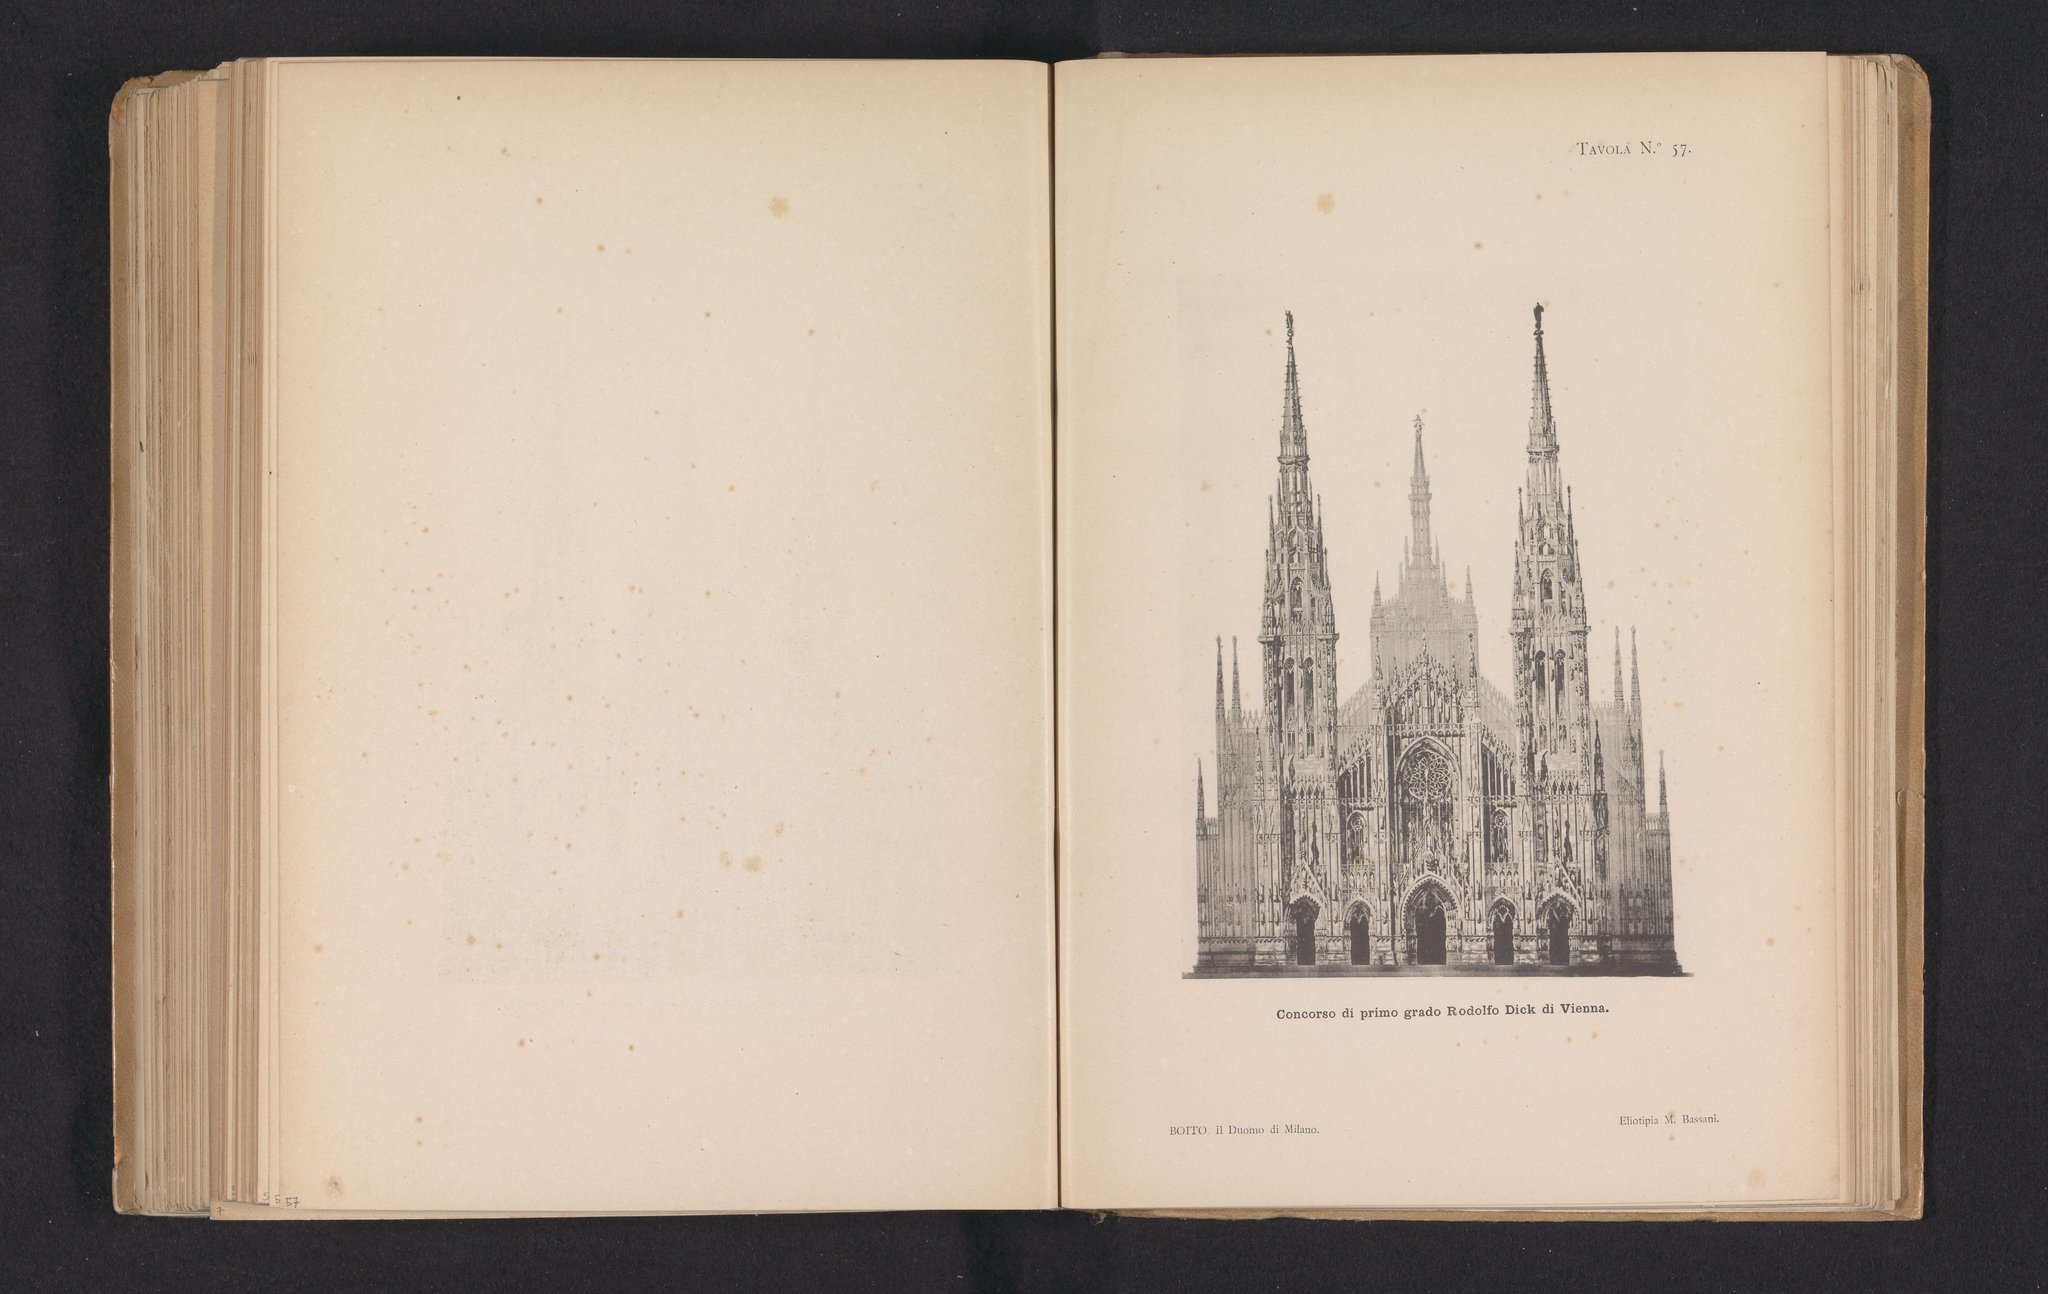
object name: page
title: Fotoreproductie van een ontwerptekening voor de façade van de Dom van Milaan door Rudolf Dick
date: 1886-1889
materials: paper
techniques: photograph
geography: milan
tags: drawing, sketch, parts of church exterior and annexes: façade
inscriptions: number: ‘Tavola No. 57.’